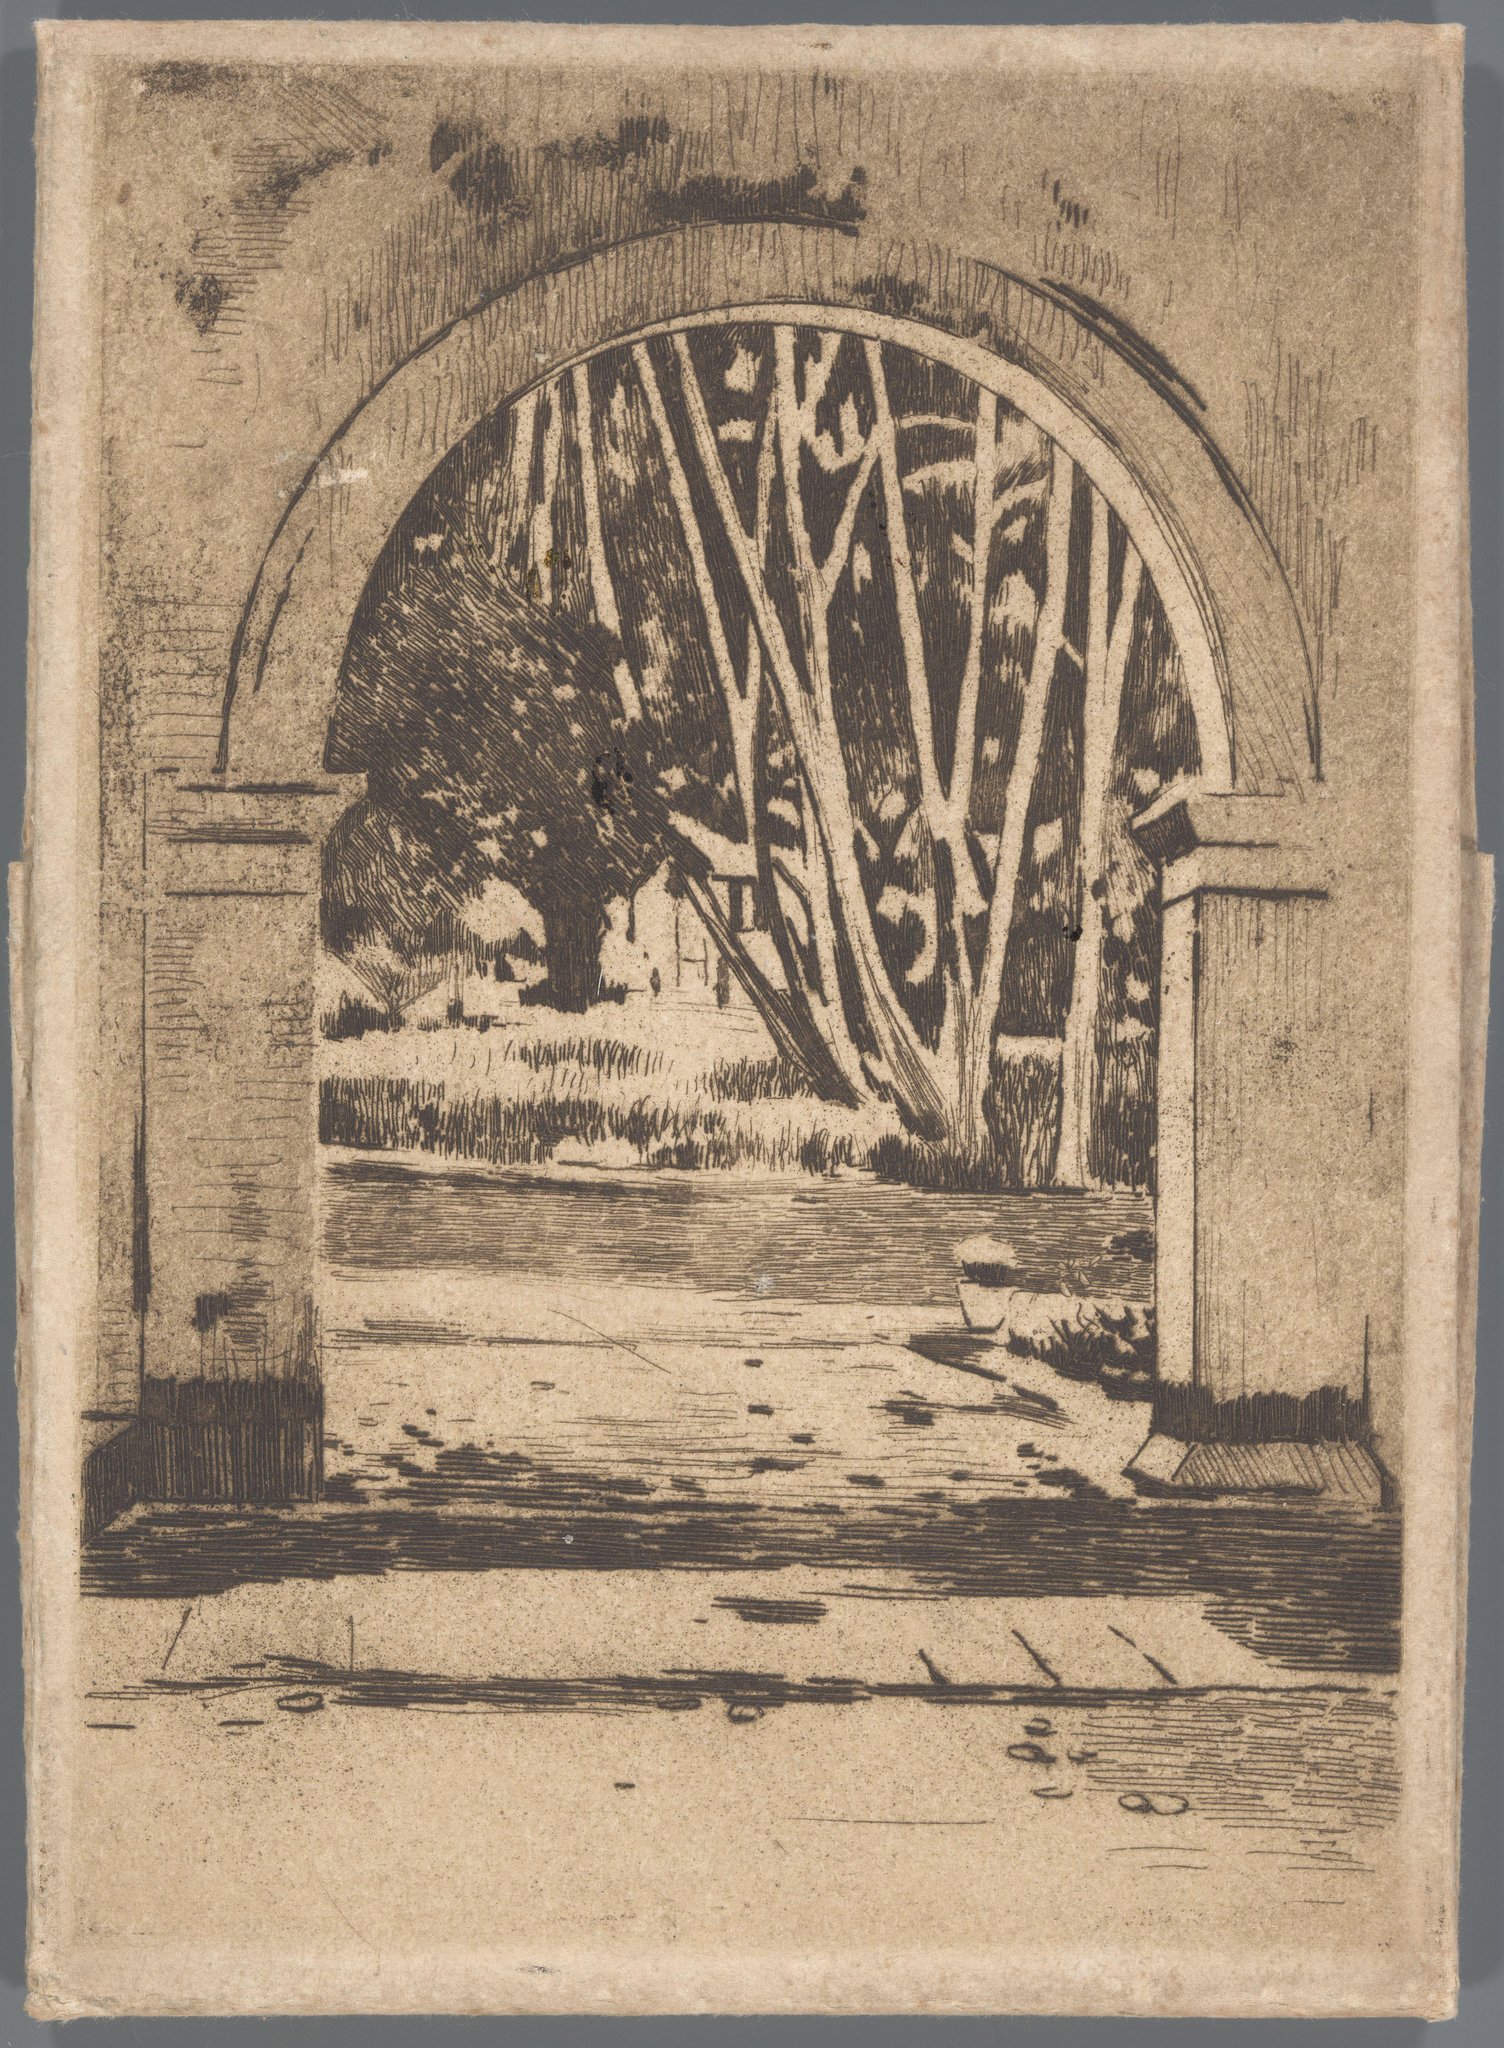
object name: print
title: Poort van Hotel Bellevue, Buitenzorg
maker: willem witsen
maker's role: draughtsman, painter, print maker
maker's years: 1860-1923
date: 1921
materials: paper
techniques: etching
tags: gate, entrance